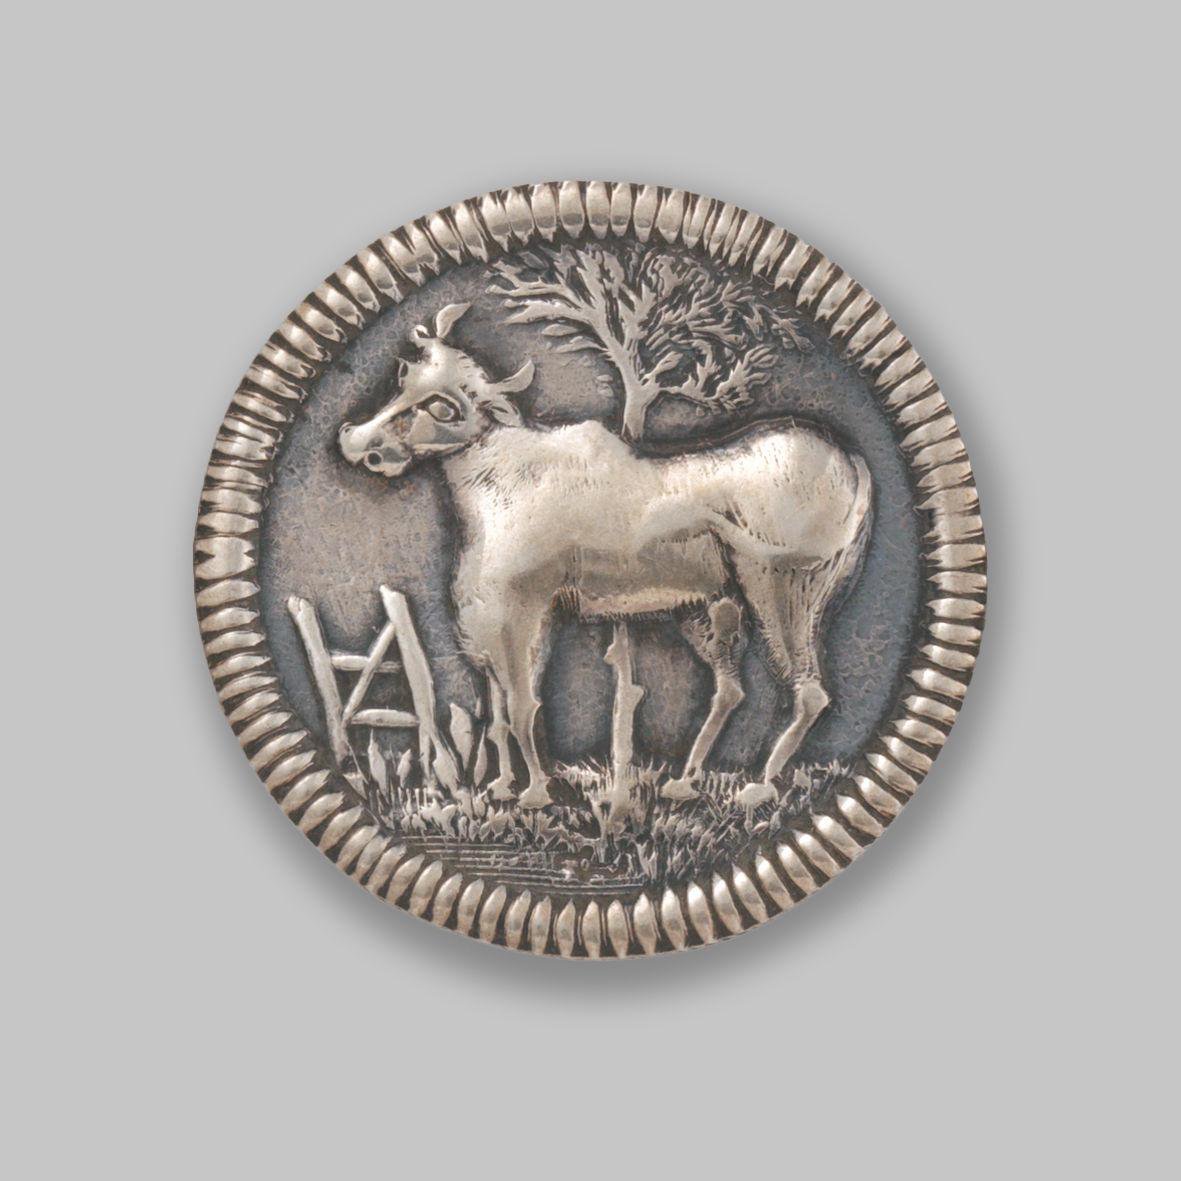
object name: button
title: Knoop met voorstelling van een koe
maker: Anonymous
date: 1850-1900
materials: silver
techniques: casting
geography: netherlands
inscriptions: alloy mark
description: Knoop van gegoten zilver, rond, met op de voorzijde een koe in een weiland omgeven door een geribde rand. Aan de achterzijde is een uit gebogen draad vervaardigd oog bevestigd.